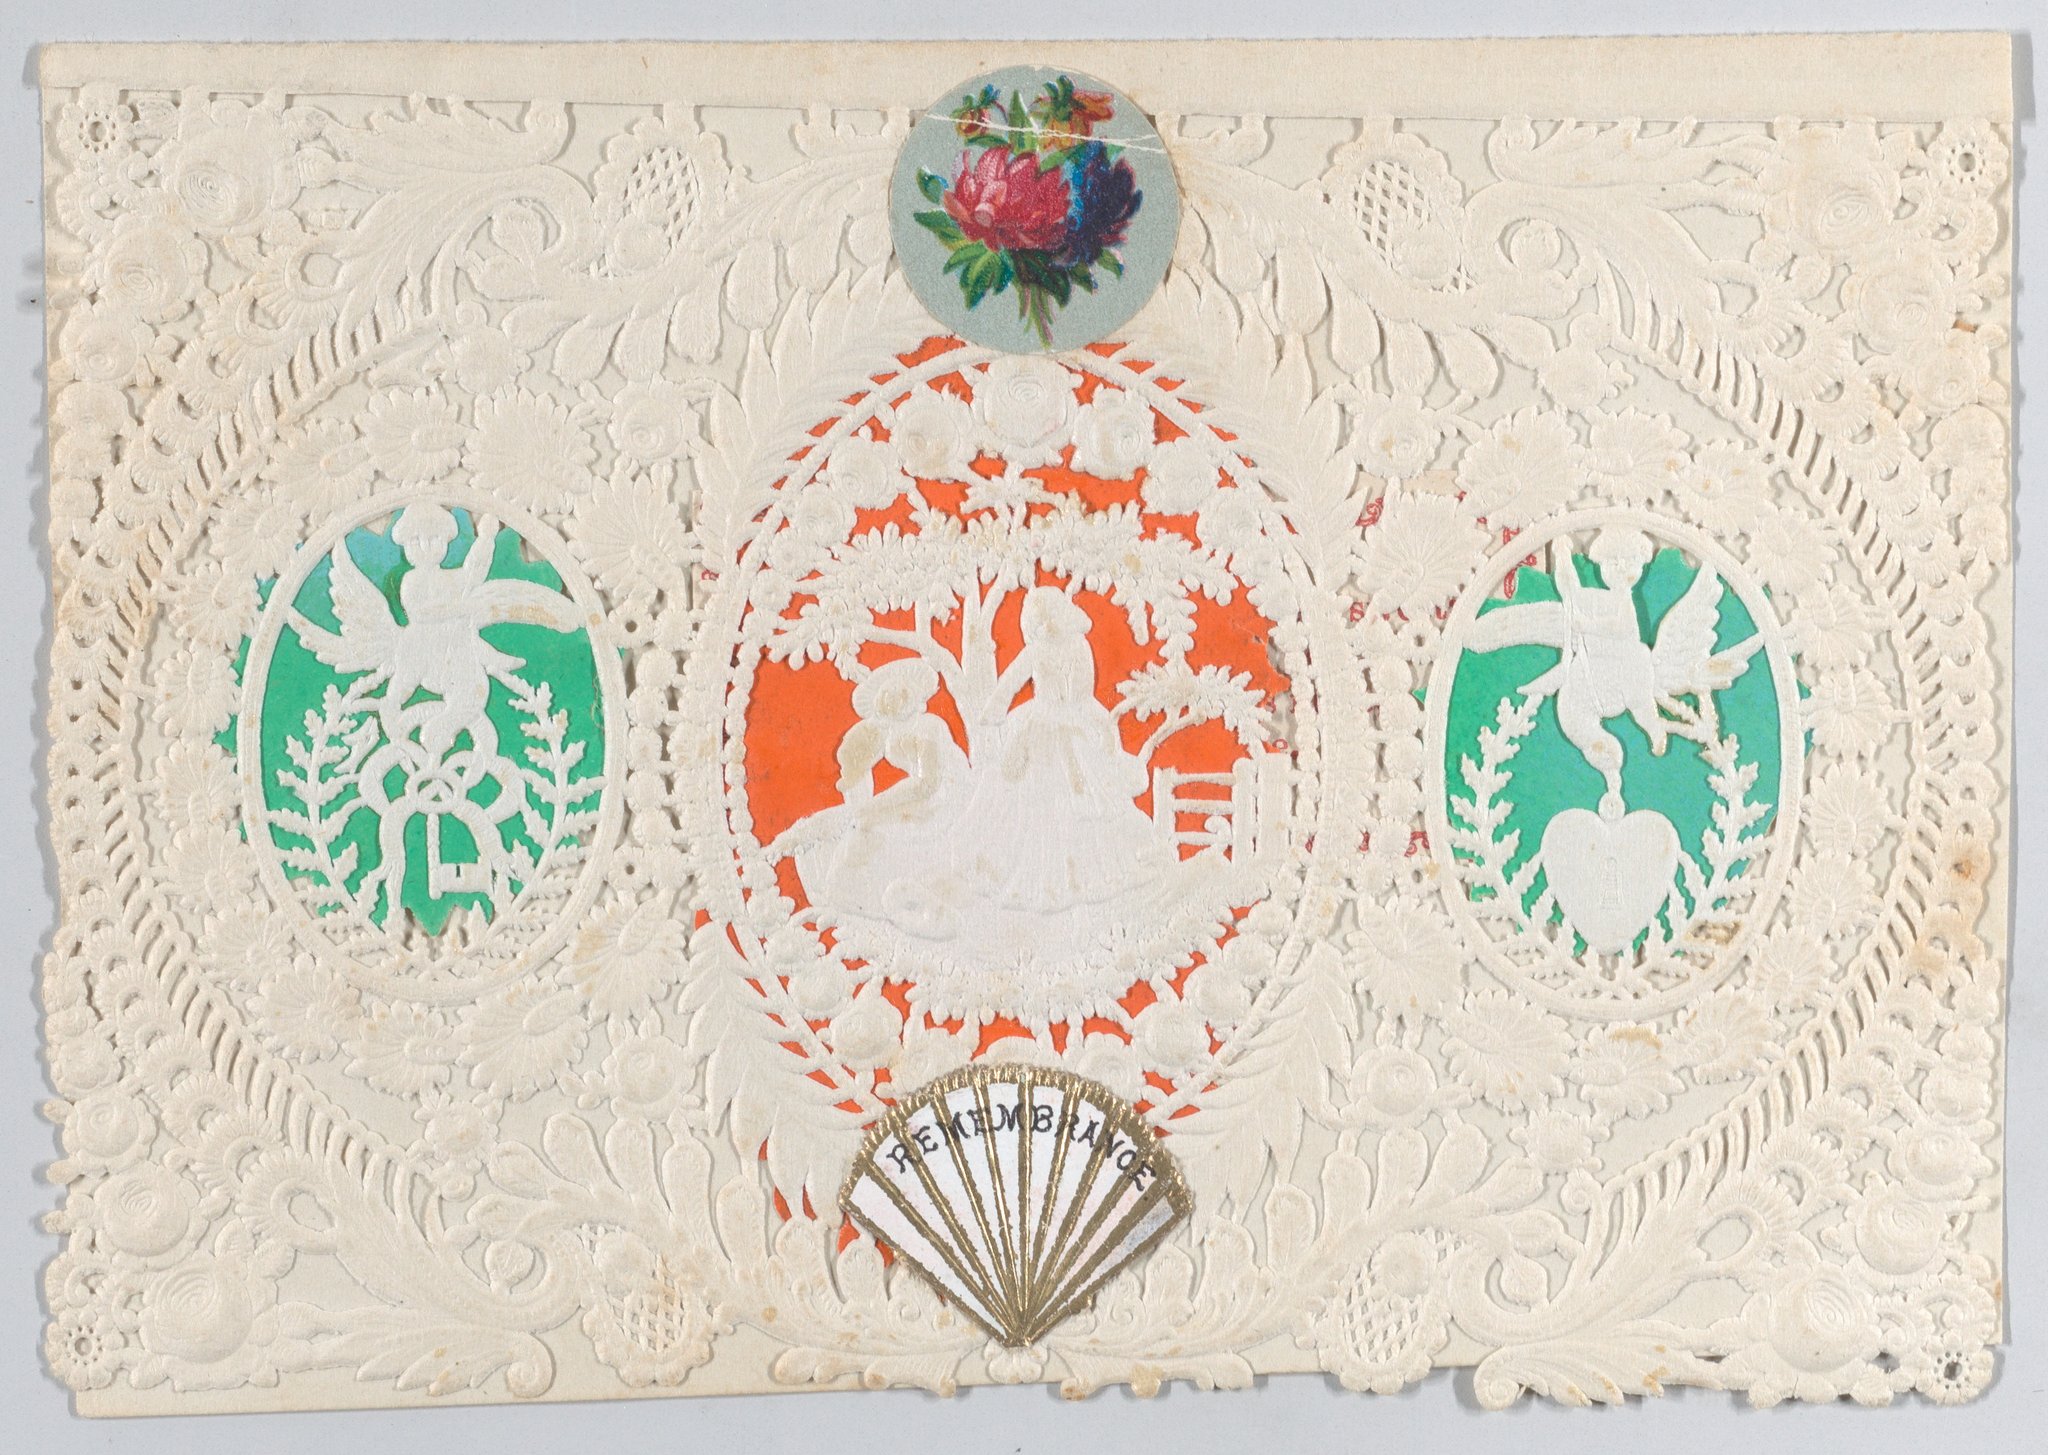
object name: valentine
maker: Anonymous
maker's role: artist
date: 1850-1870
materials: lace, paper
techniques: chromolithography, embossing, open work